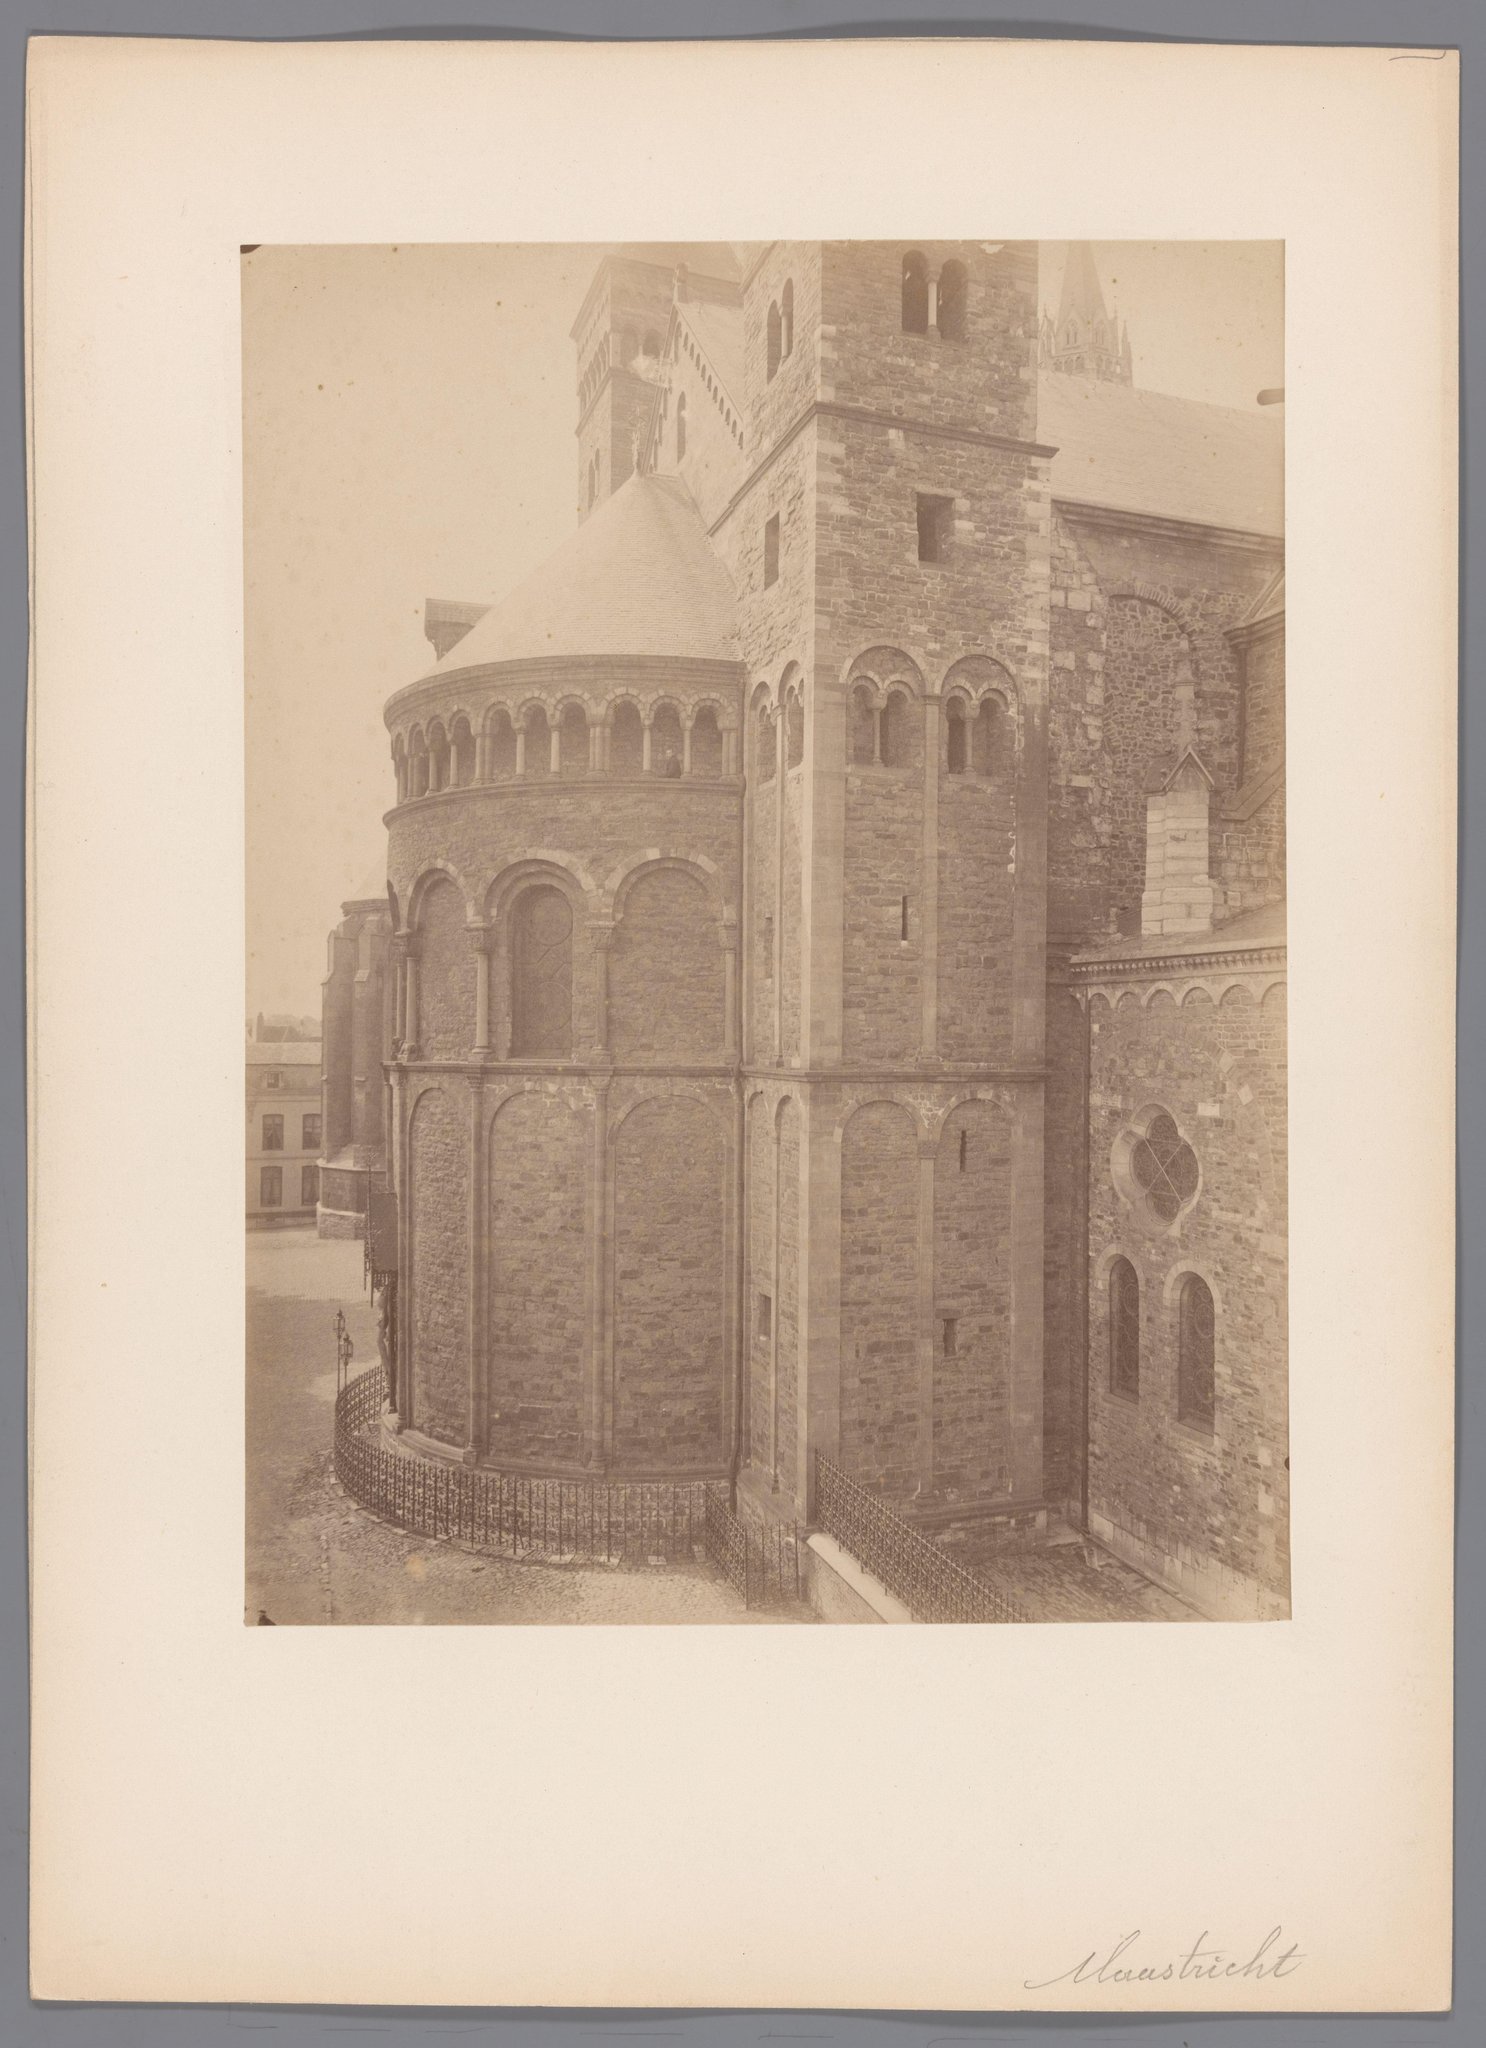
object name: photograph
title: Noordzijde van het koor van de Sint-Servaasbasiliek te Maastricht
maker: anoniem (monumentenzorg)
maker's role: fotograaf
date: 1893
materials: cardboard, photographic support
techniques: albumen print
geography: maastricht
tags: parts of church exterior and annexes: choir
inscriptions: annotation: ‘St. Servaaskerk te Maastricht/ Het koorgedeelte van uit het noorden/ Mei 1890’, annotation: ‘Maastricht’